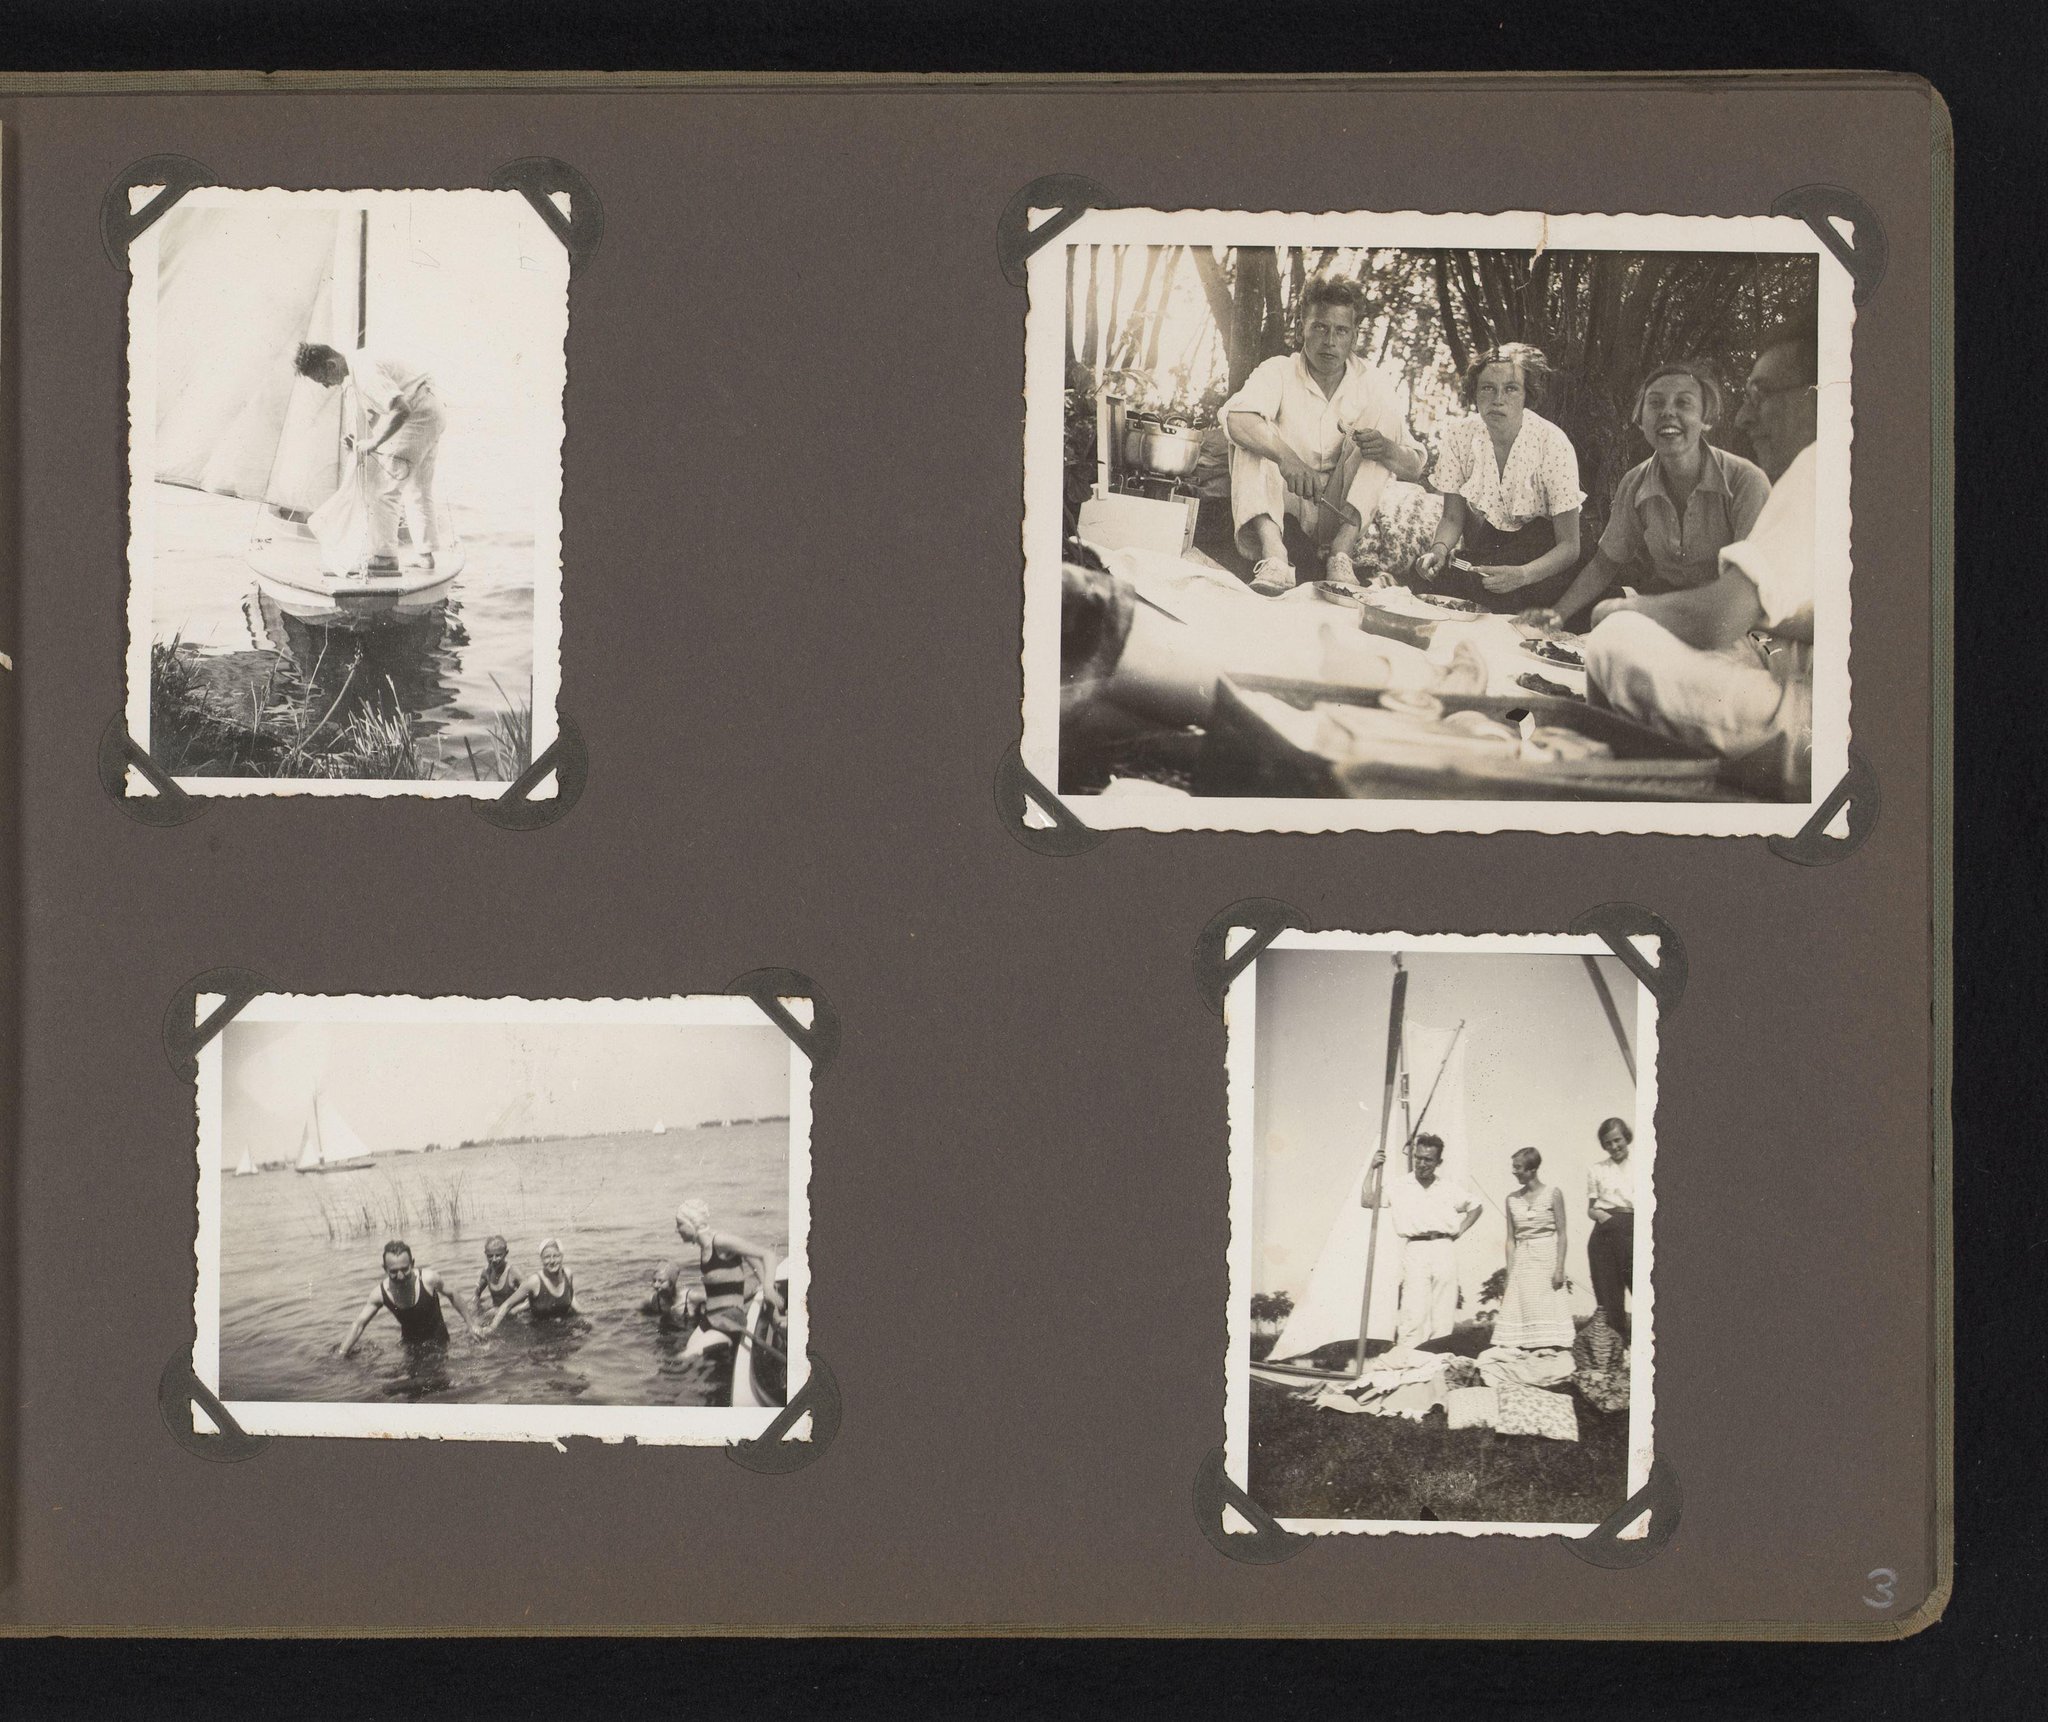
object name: album leaf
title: Picknicken en zeilen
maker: Anonymous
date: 1935-1945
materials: cardboard, photographic support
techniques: gelatin silver print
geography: netherlands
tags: students' organization, student vacation, outing, pleasure trip, netherlands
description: Albumblad met vier foto's van een zeiltochtje, zwemmen en een picknick met vrienden. Onderdeel van het fotoalbum van een jonge vrouw, ca. 1935-1945.